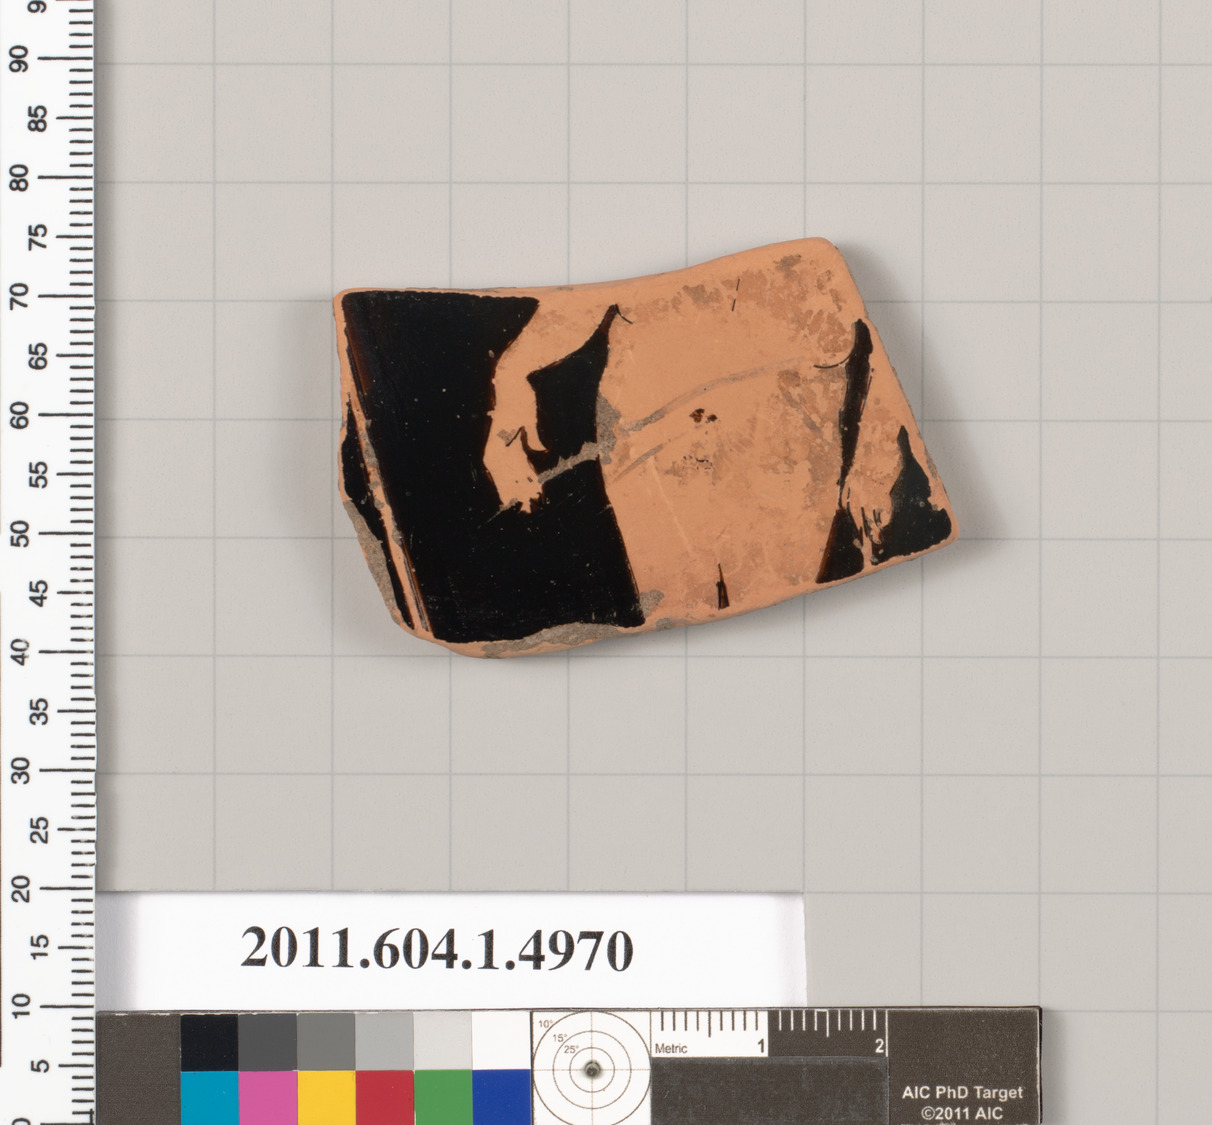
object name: kylix fragment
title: Terracotta fragment of a kylix (drinking cup)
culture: greek, attic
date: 475-451 BCE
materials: terracotta